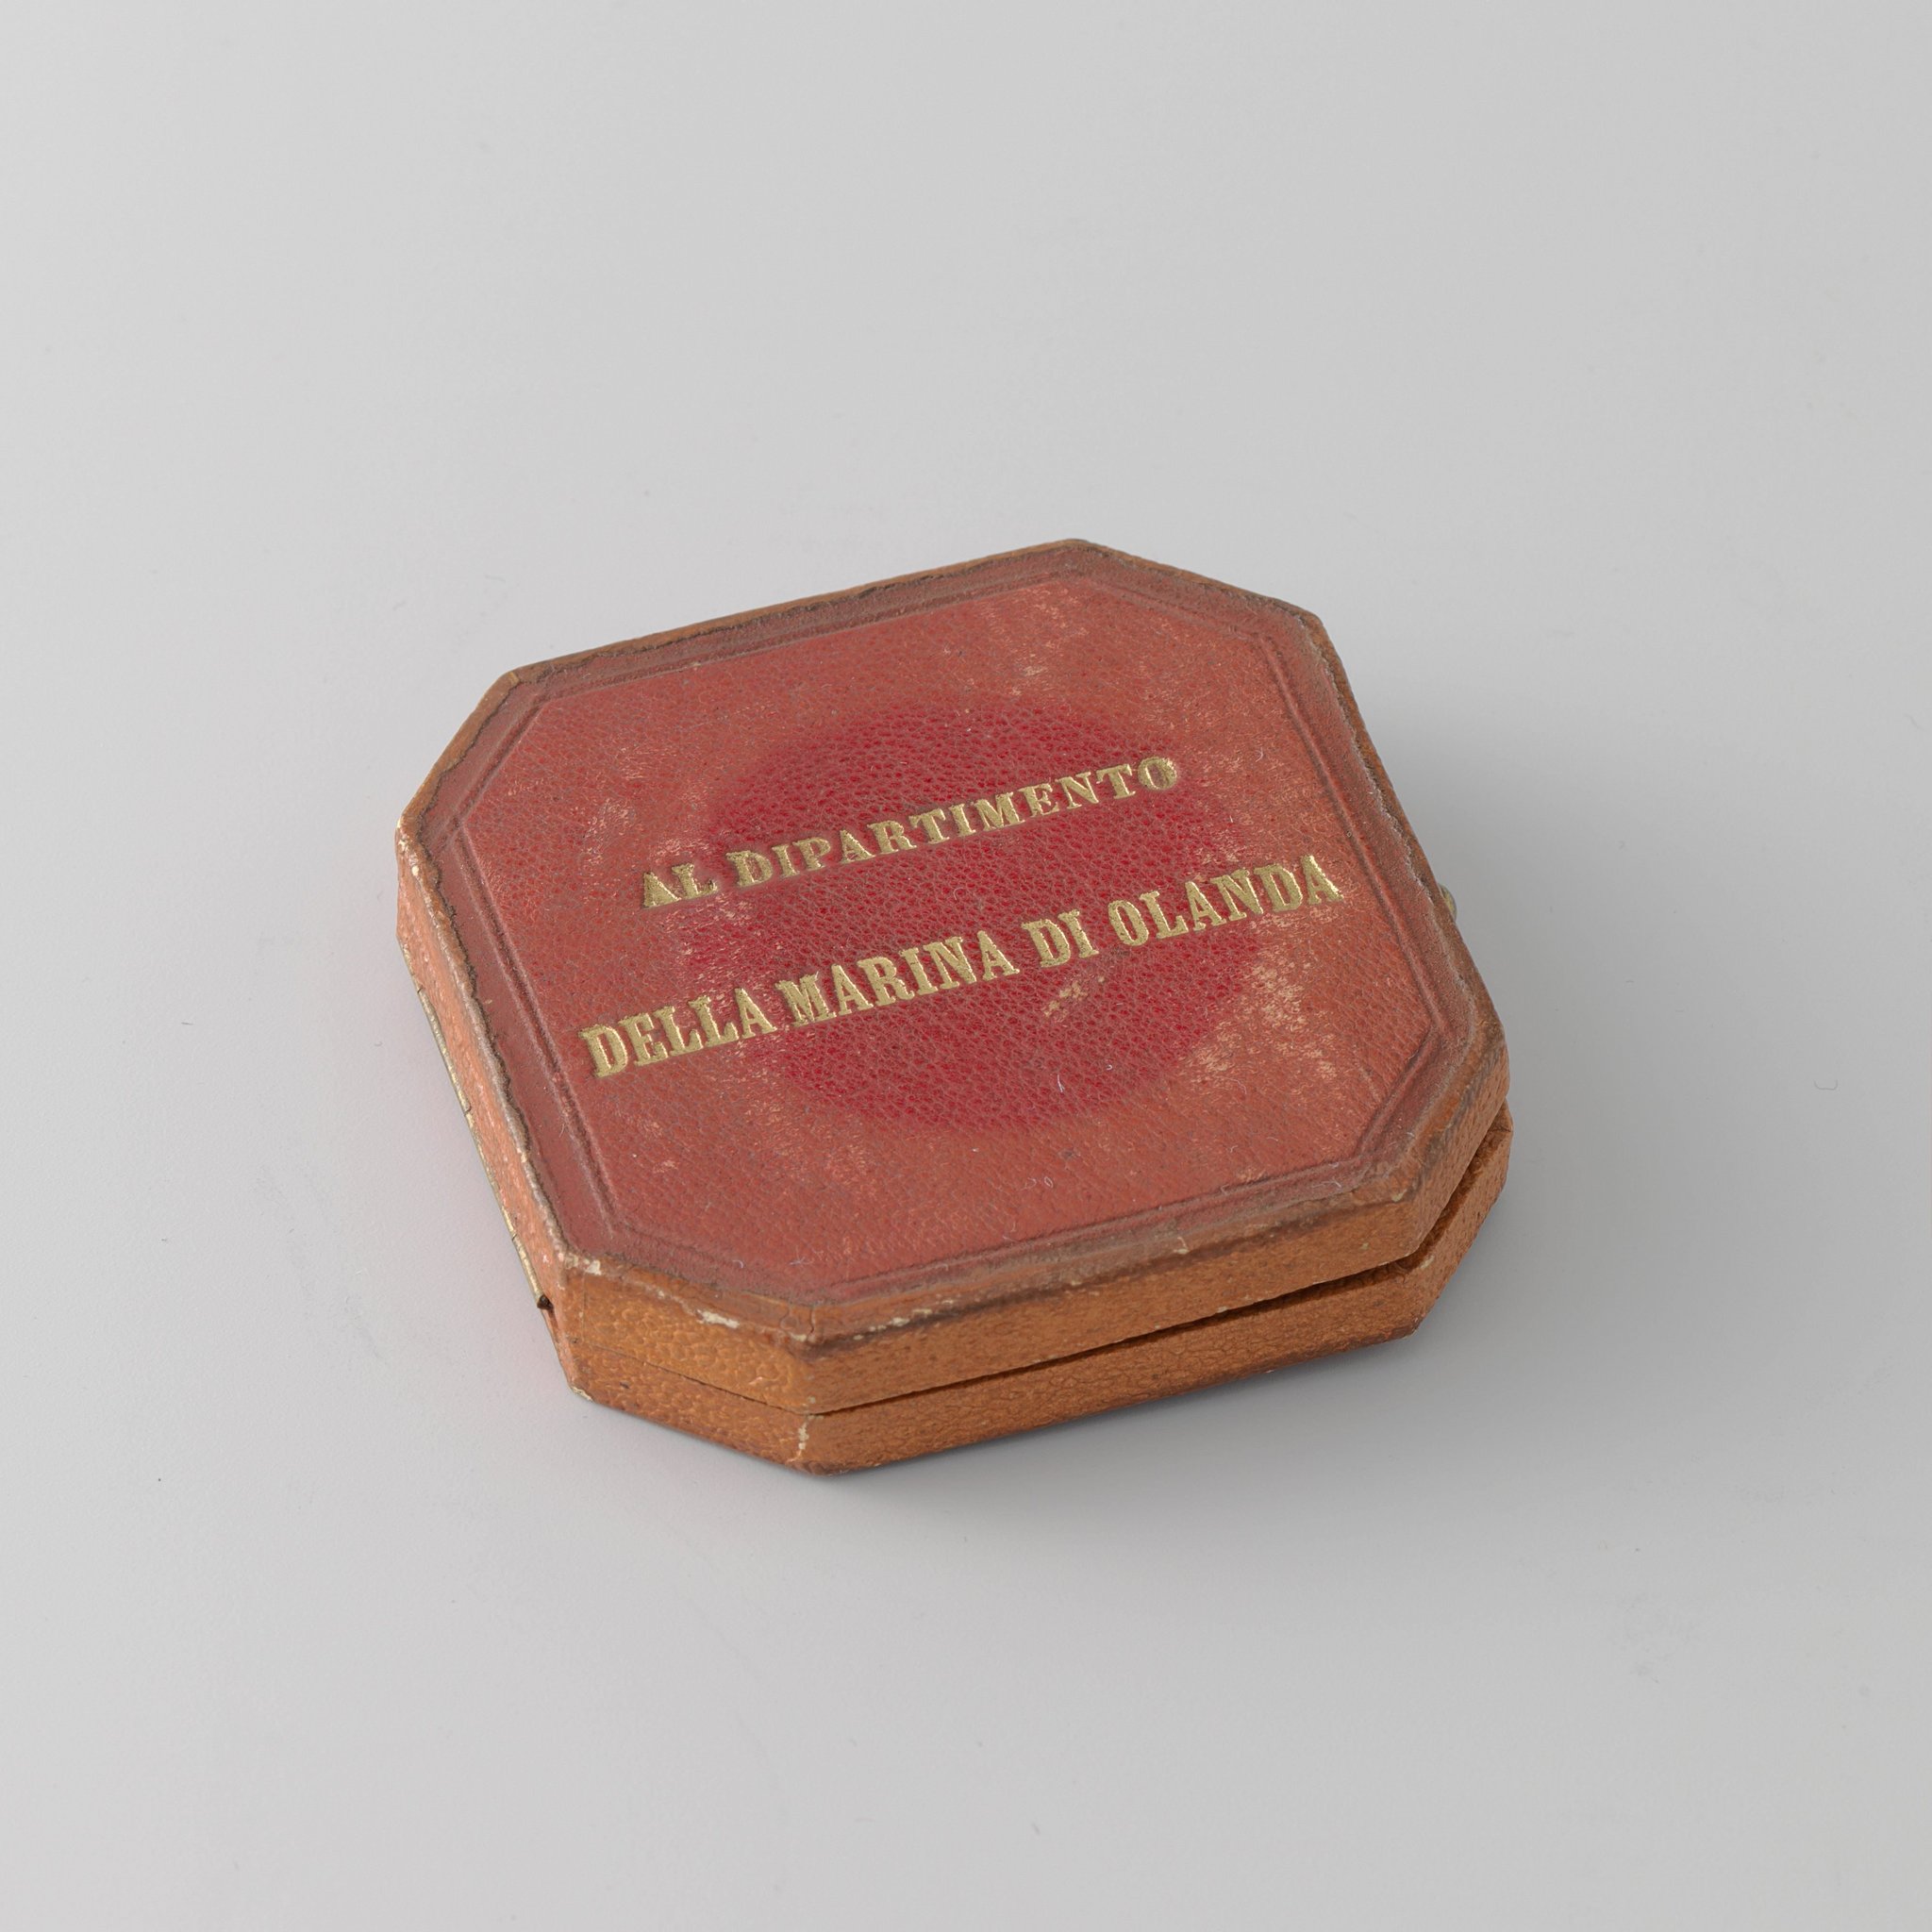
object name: medal box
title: Box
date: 1871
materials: cardboard, leather, silk, velvet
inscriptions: inscription, on the box: ‘AL DIPARTIMENTO / DELLA MARINA DI OLANDA’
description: Achtkantig doosje met rood leer bekleed met opschrift in goud. Het Ministerie van Marine ontving deze medaille voor haar deelname aan de tentoonstelling in Napels in 1871.